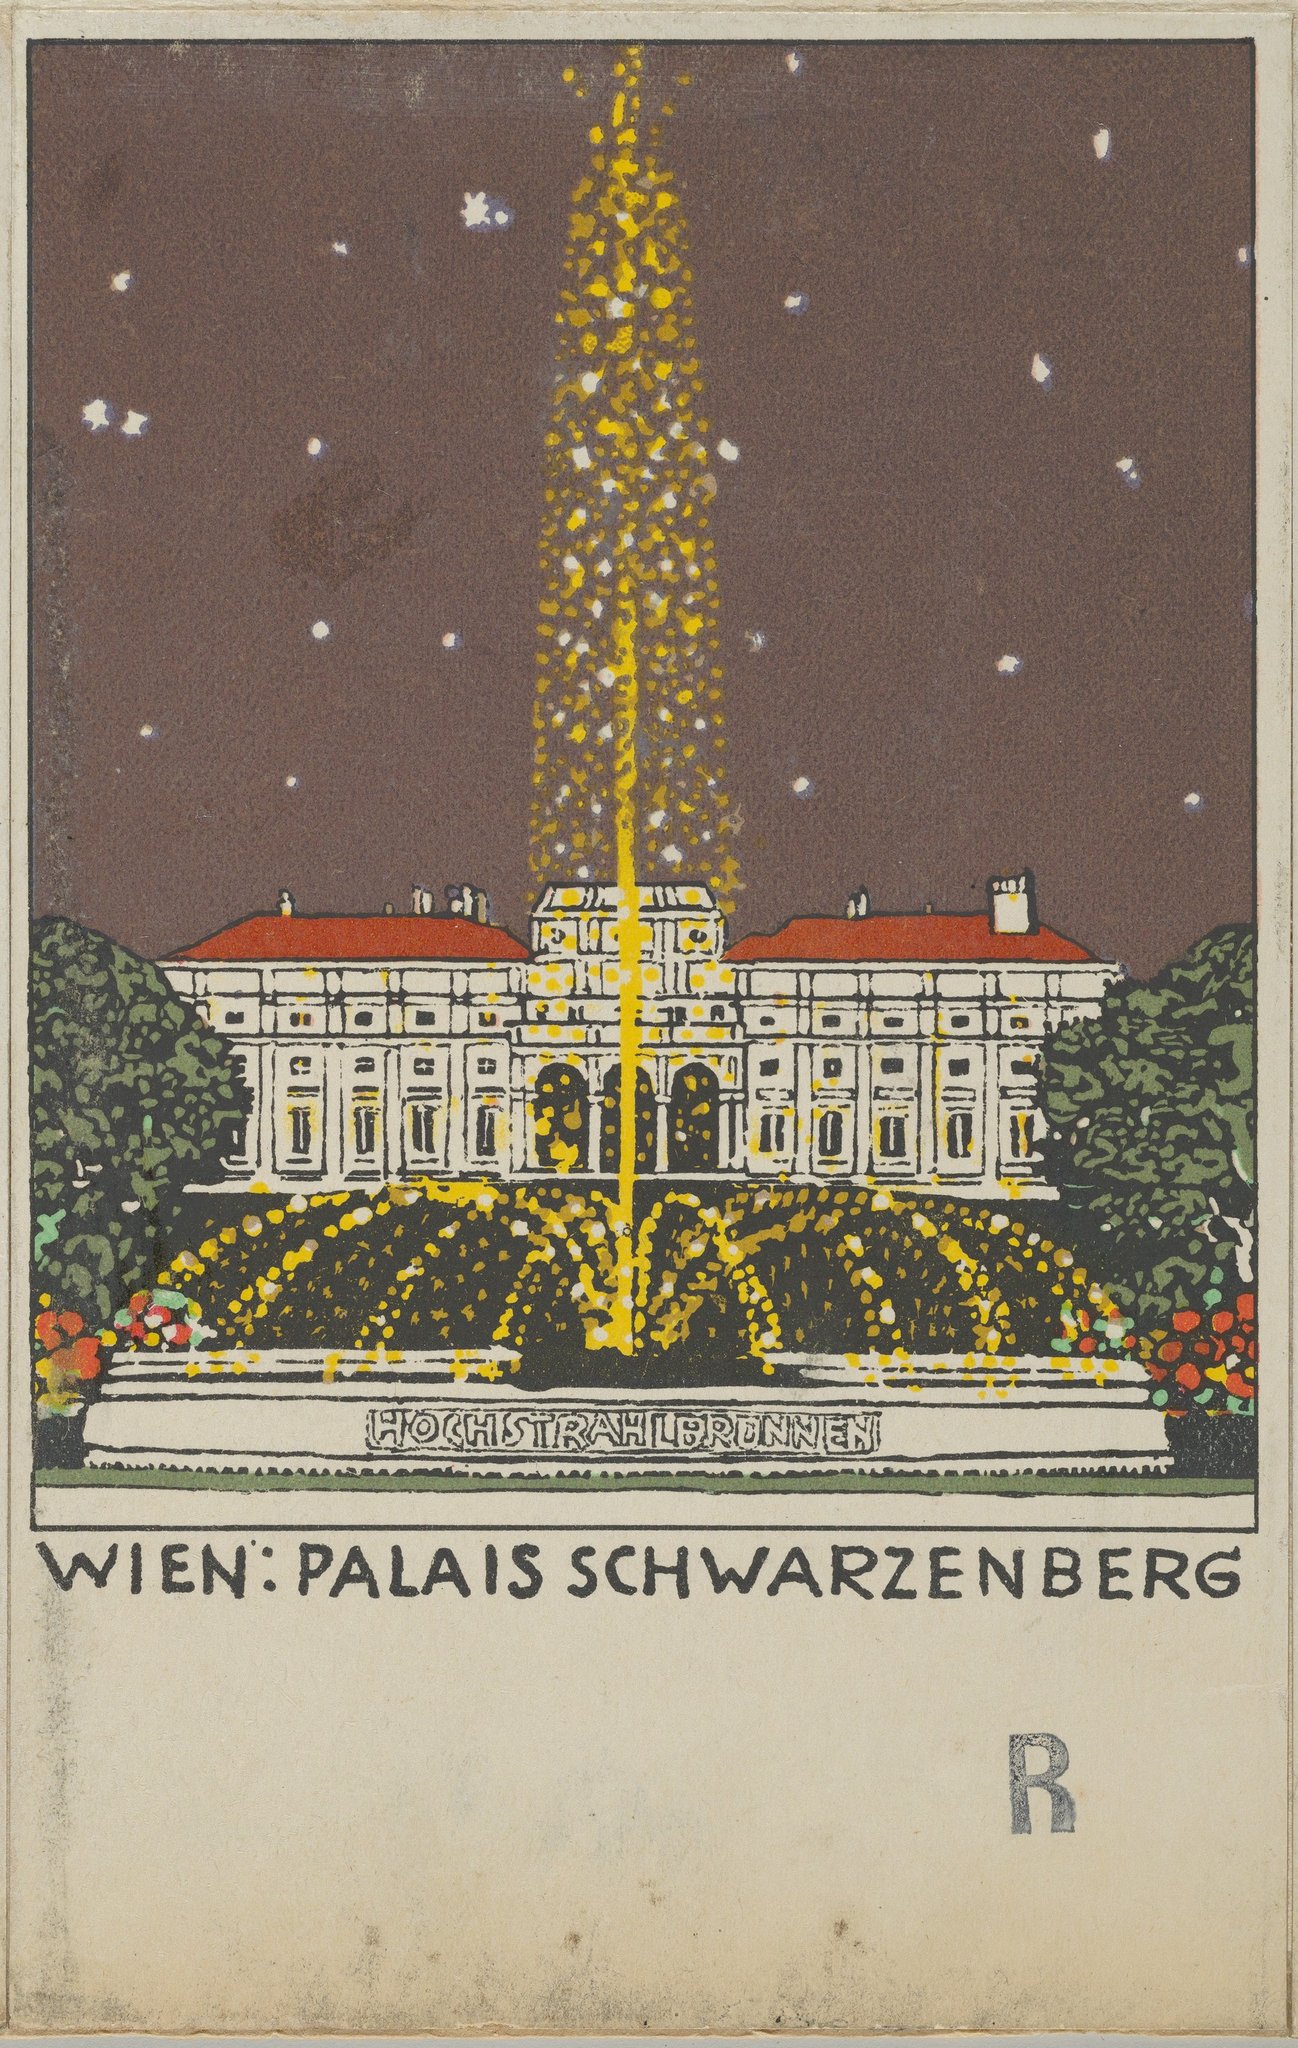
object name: print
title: Vienna: Palais Schwarzenberg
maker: urban janke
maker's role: artist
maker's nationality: austrian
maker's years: 1887-1914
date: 1908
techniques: lithograph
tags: fountains,palaces